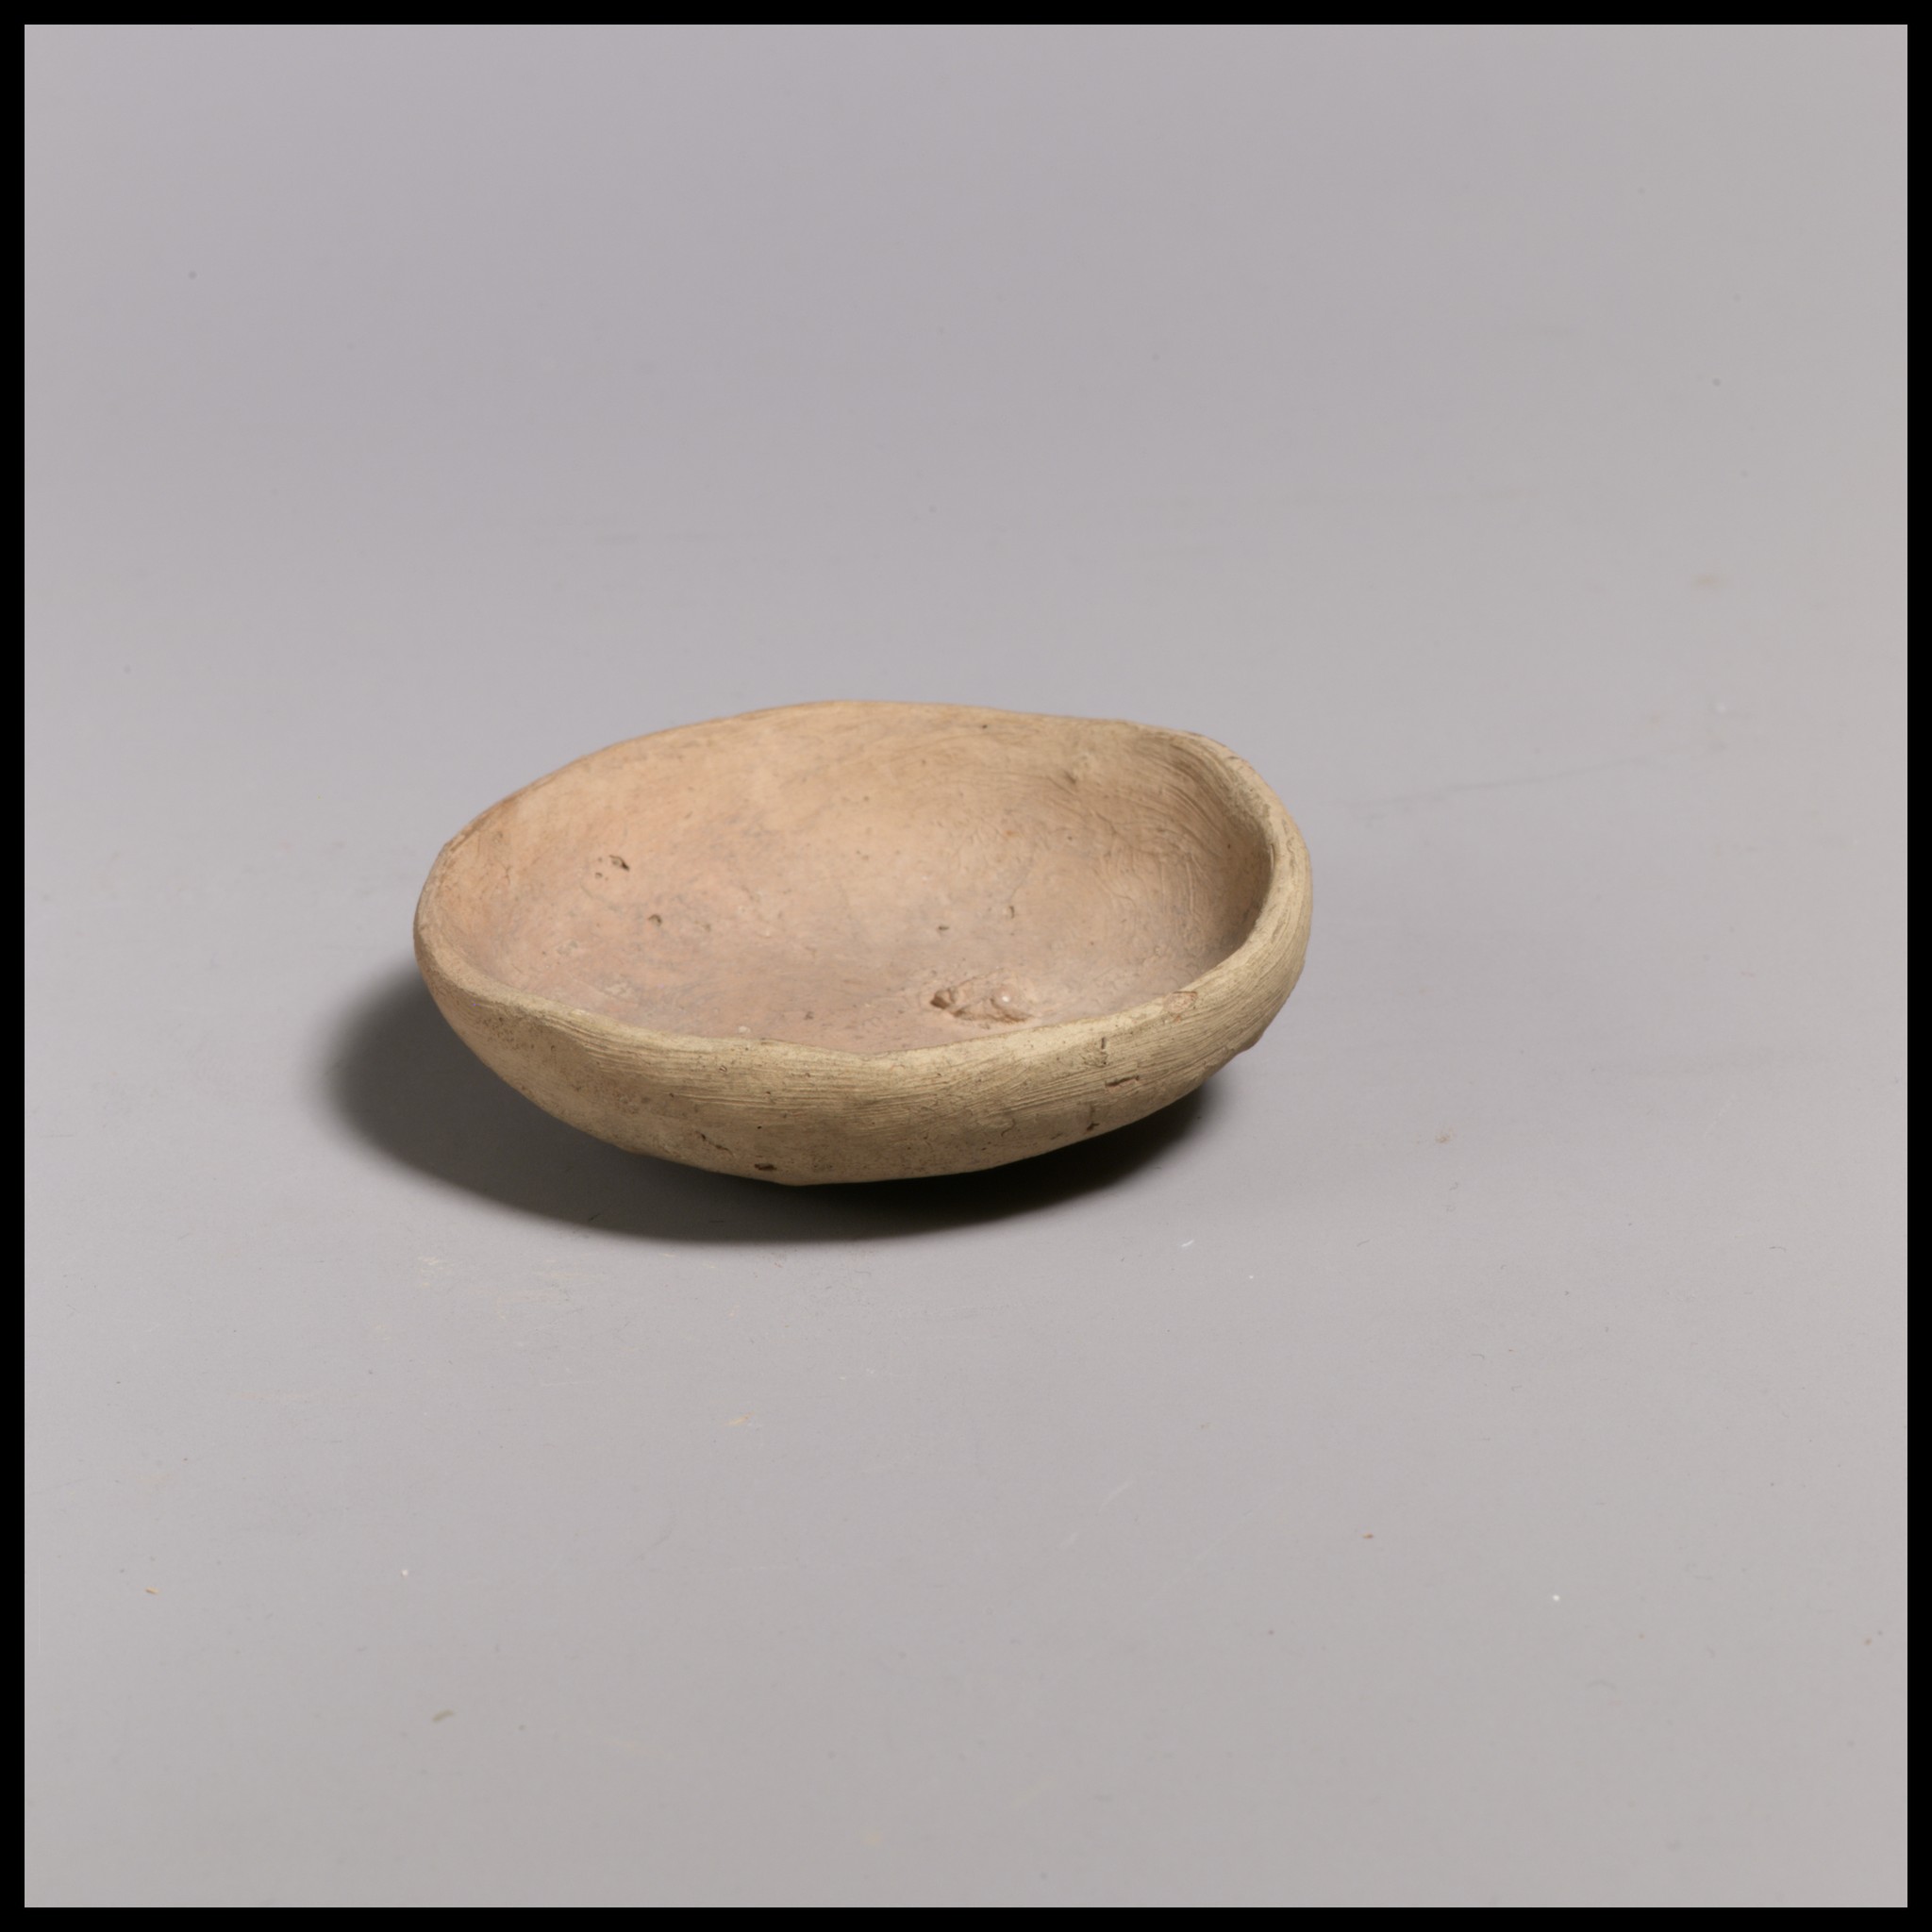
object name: saucer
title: Terracotta saucer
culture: helladic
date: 2650-2150 BCE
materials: terracotta